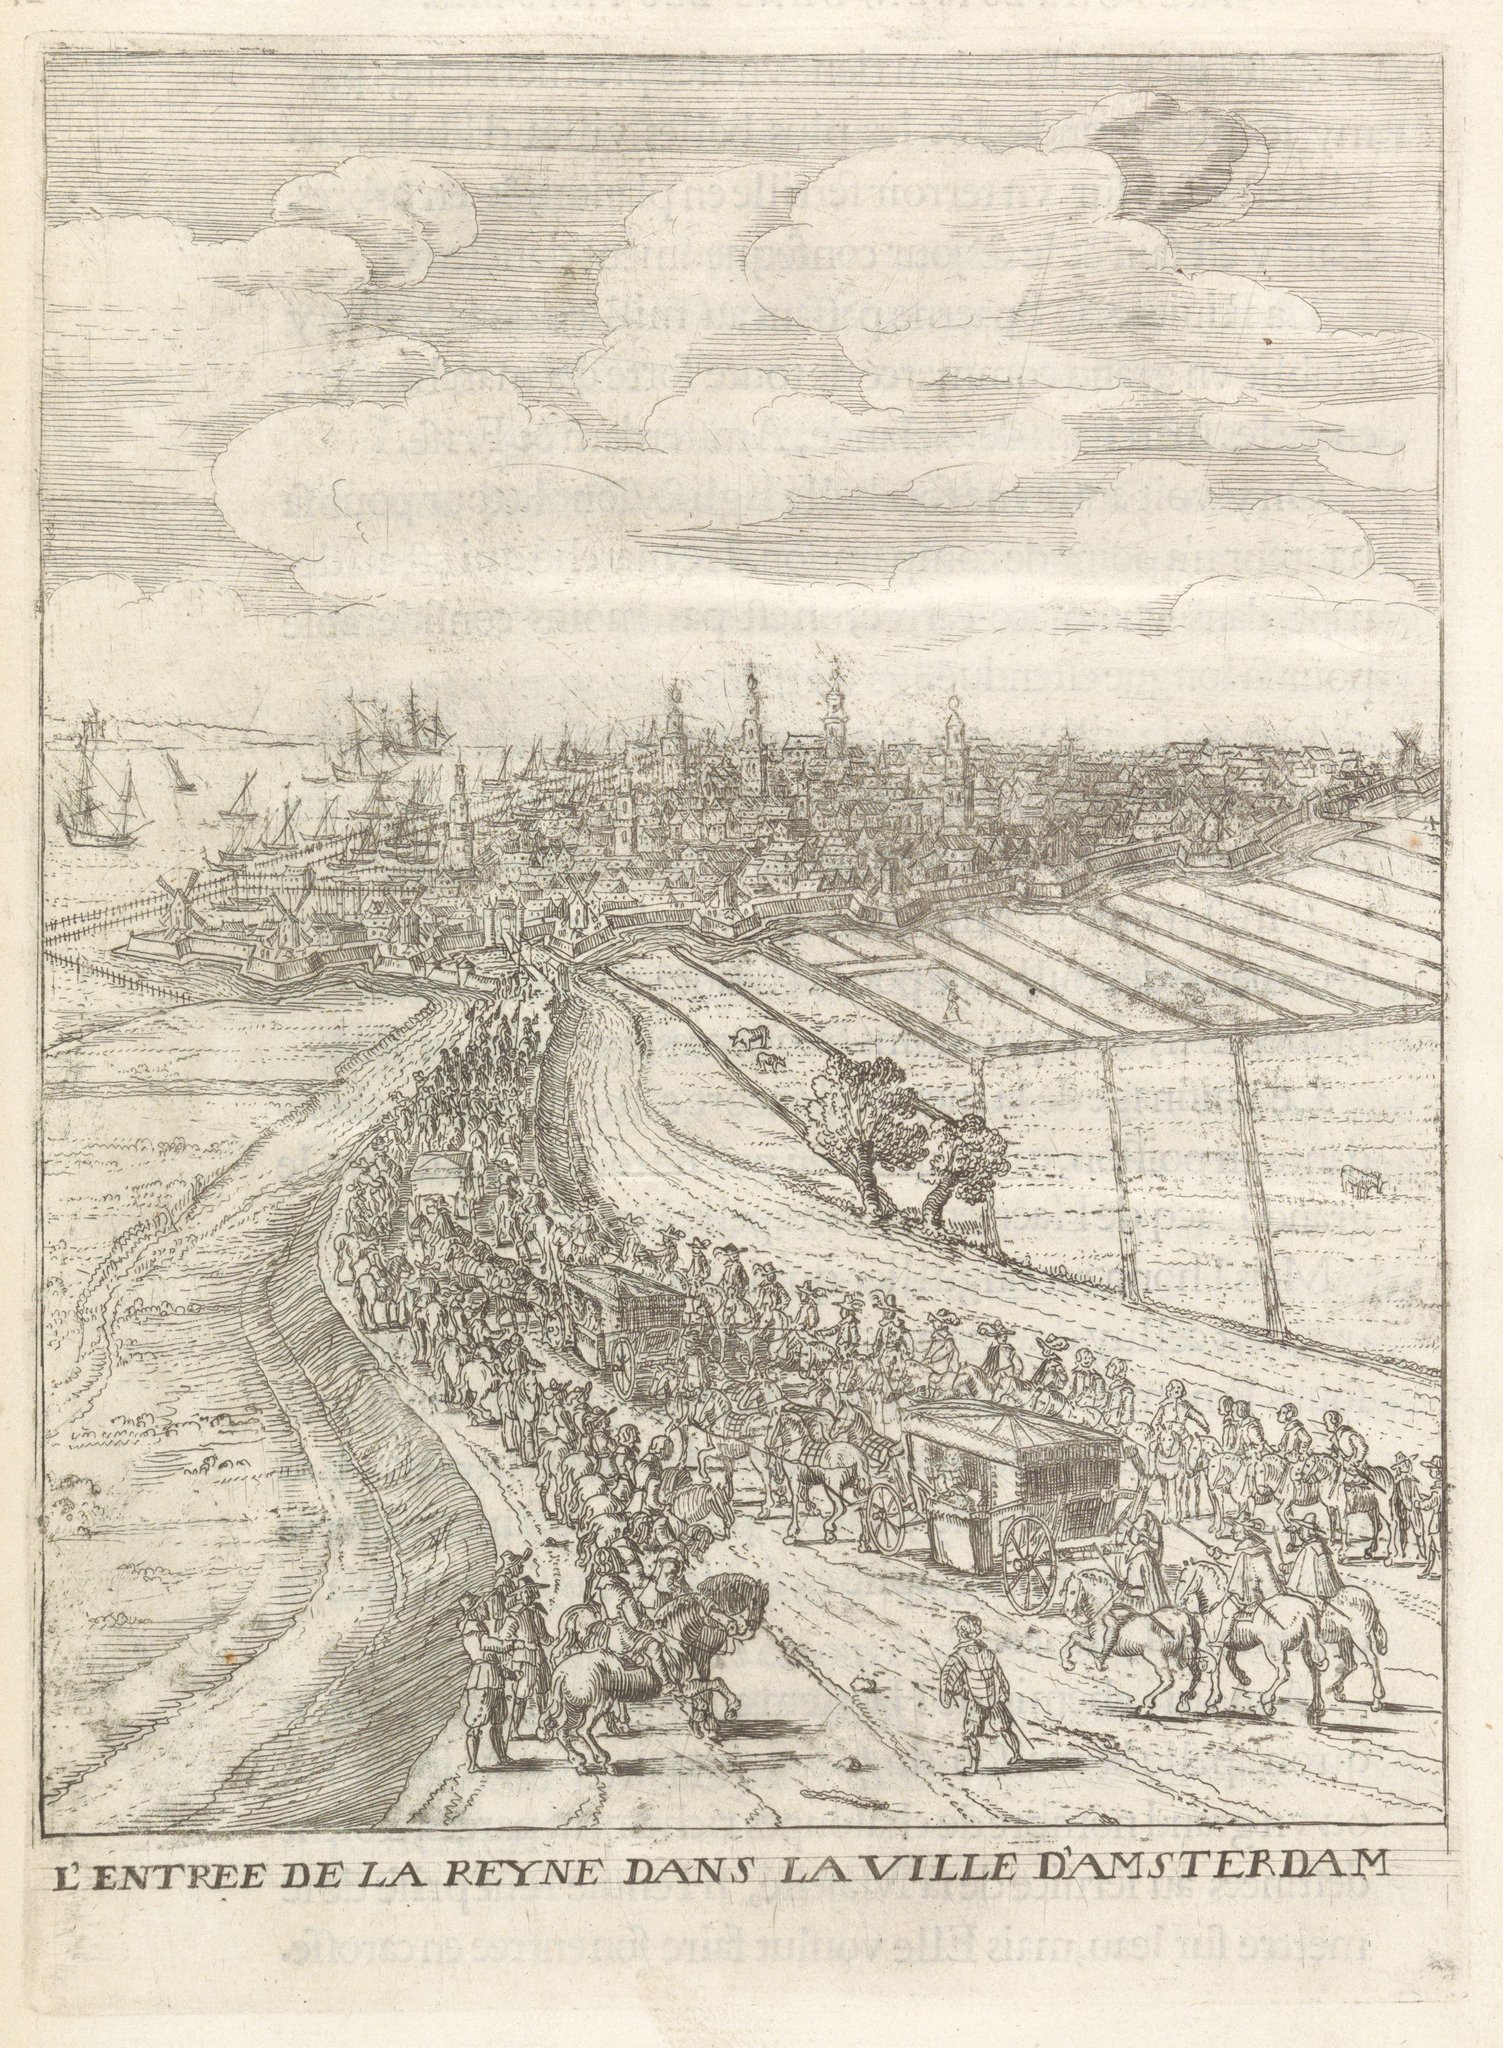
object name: print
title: Aankomst van Maria de' Medici in Amsterdam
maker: Anonymous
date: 1639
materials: paper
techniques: etching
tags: cologne, maria de' medici, amsterdam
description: Maria de' Medici en haar gevolg voor de muren van Amsterdam. Links het IJ. De prent maakt deel uit van een boek over het bezoek van Maria de' Medici aan de Nederlanden.